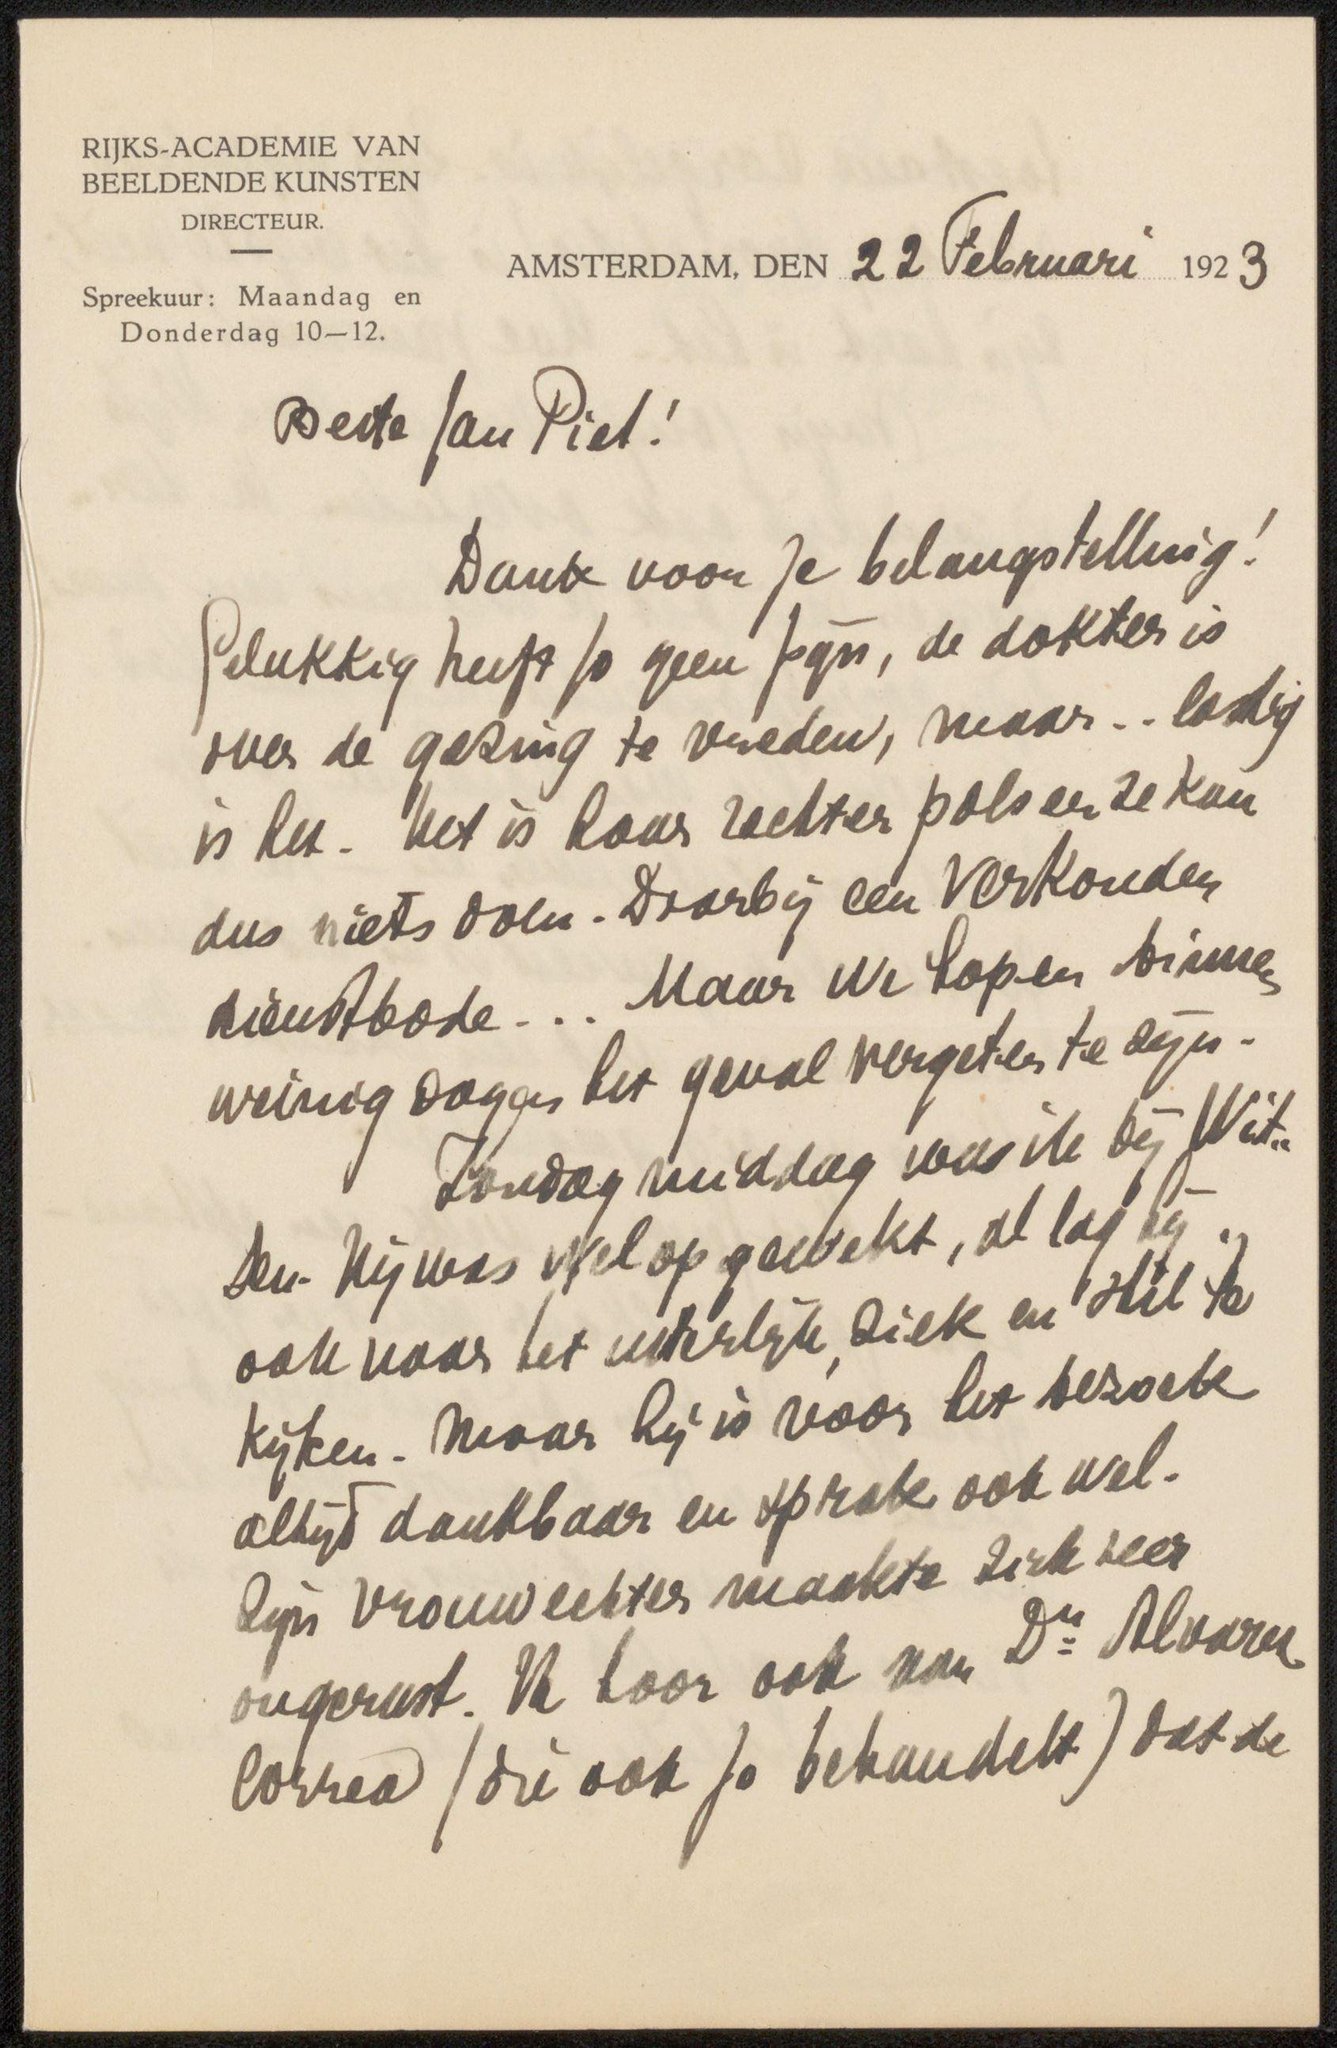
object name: letter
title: Brief aan Jan Veth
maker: antoon derkinderen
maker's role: draughtsman, painter, print maker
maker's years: 1859-1925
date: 1923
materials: ink, paper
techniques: pen, printing, writing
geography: amsterdam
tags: dordrecht, designer, jan veth, utrecht, johanna henriëtte besier, amsterdam, painter, print maker, draughtsman, willem witsen, jan van wijk (1890-1923), diseases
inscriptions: collector's mark: ‘RPK’